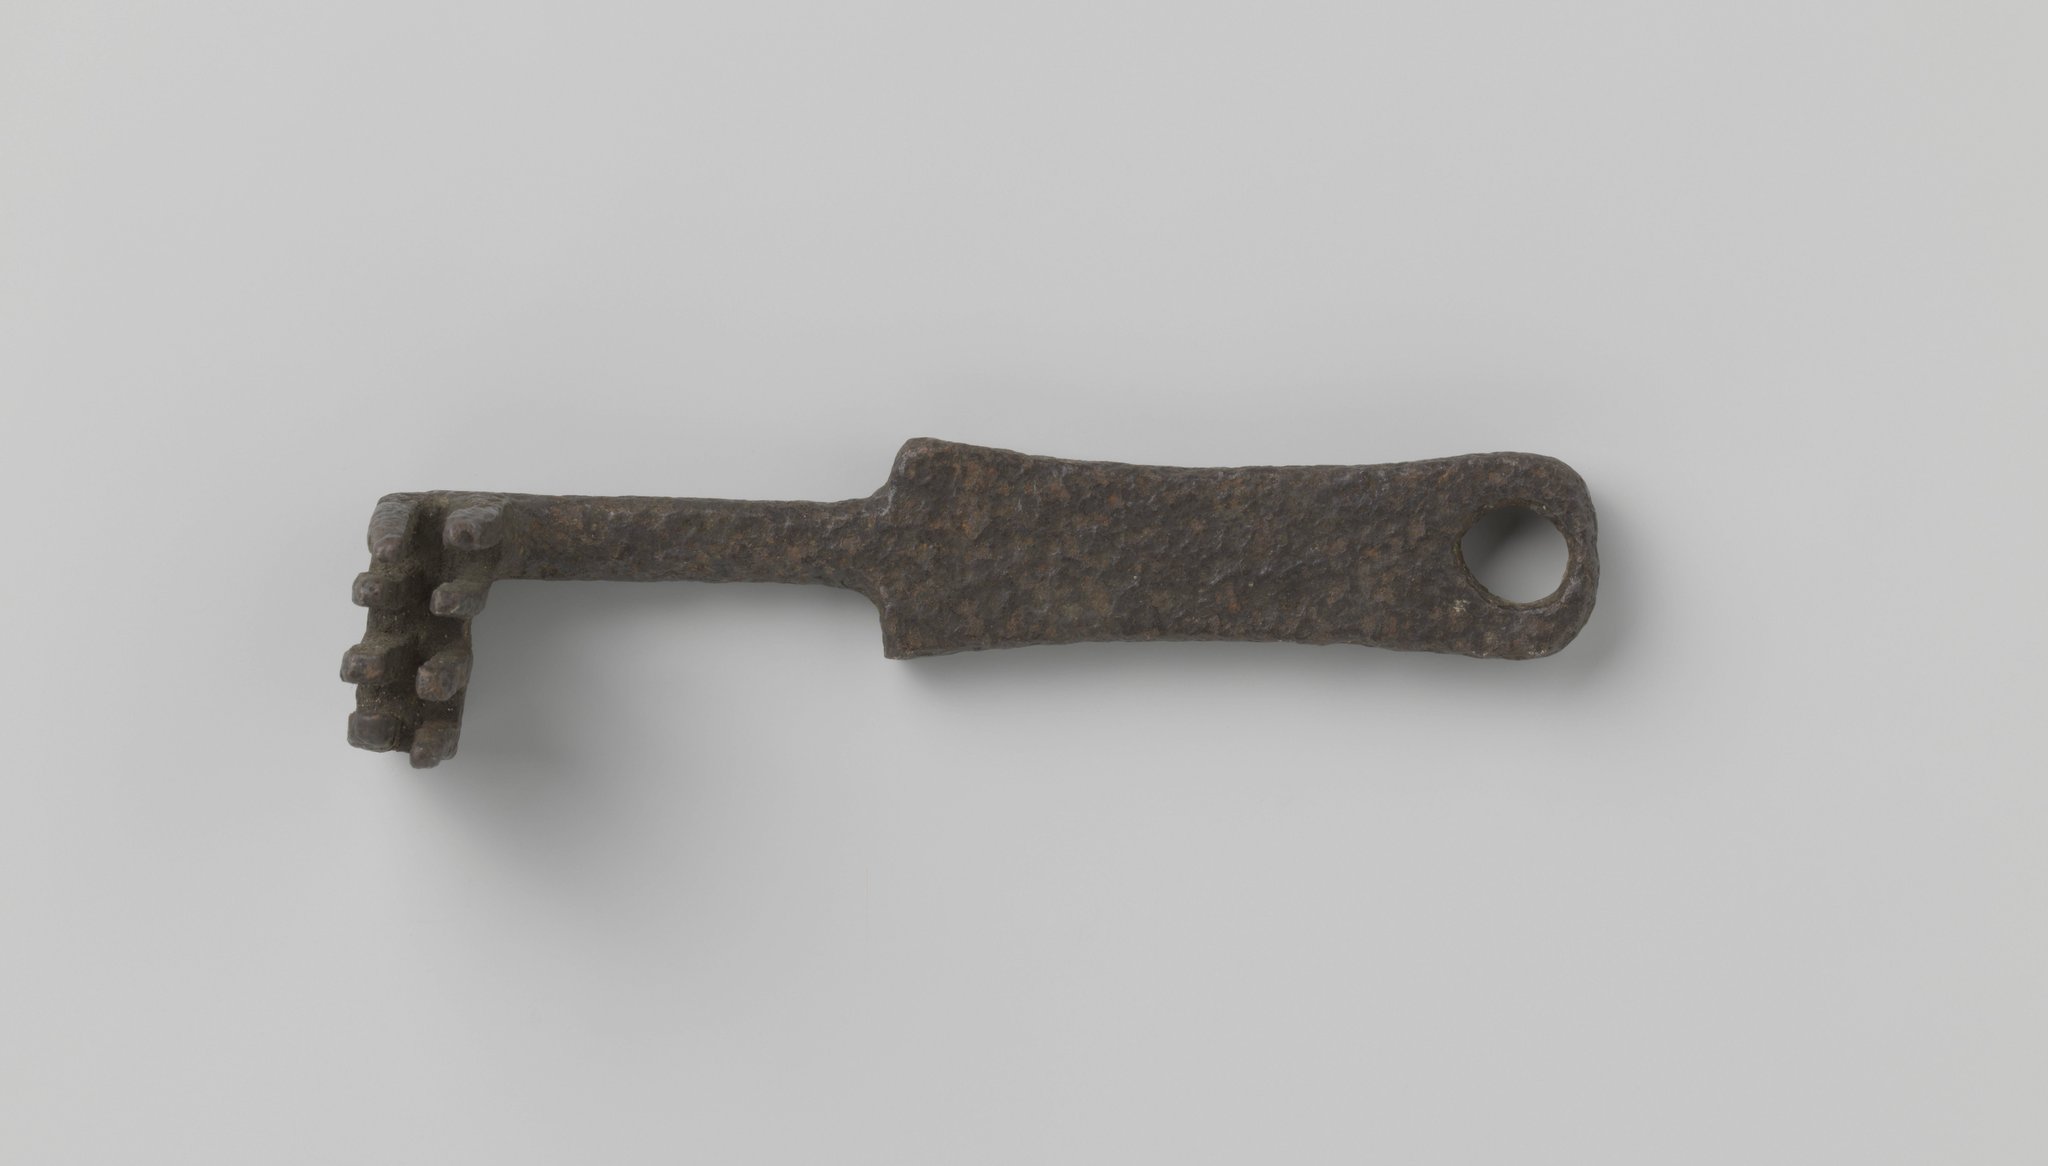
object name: hefsleutel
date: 1400-1950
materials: iron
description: Hefsleutel waarvan de baard uit een dubbele rij van vier tanden bestaat. De vierkantige steel verbreedt zich in het midden tot de greep. Deze heeft twee concaaf smalle zijden met bovenaan een oog.